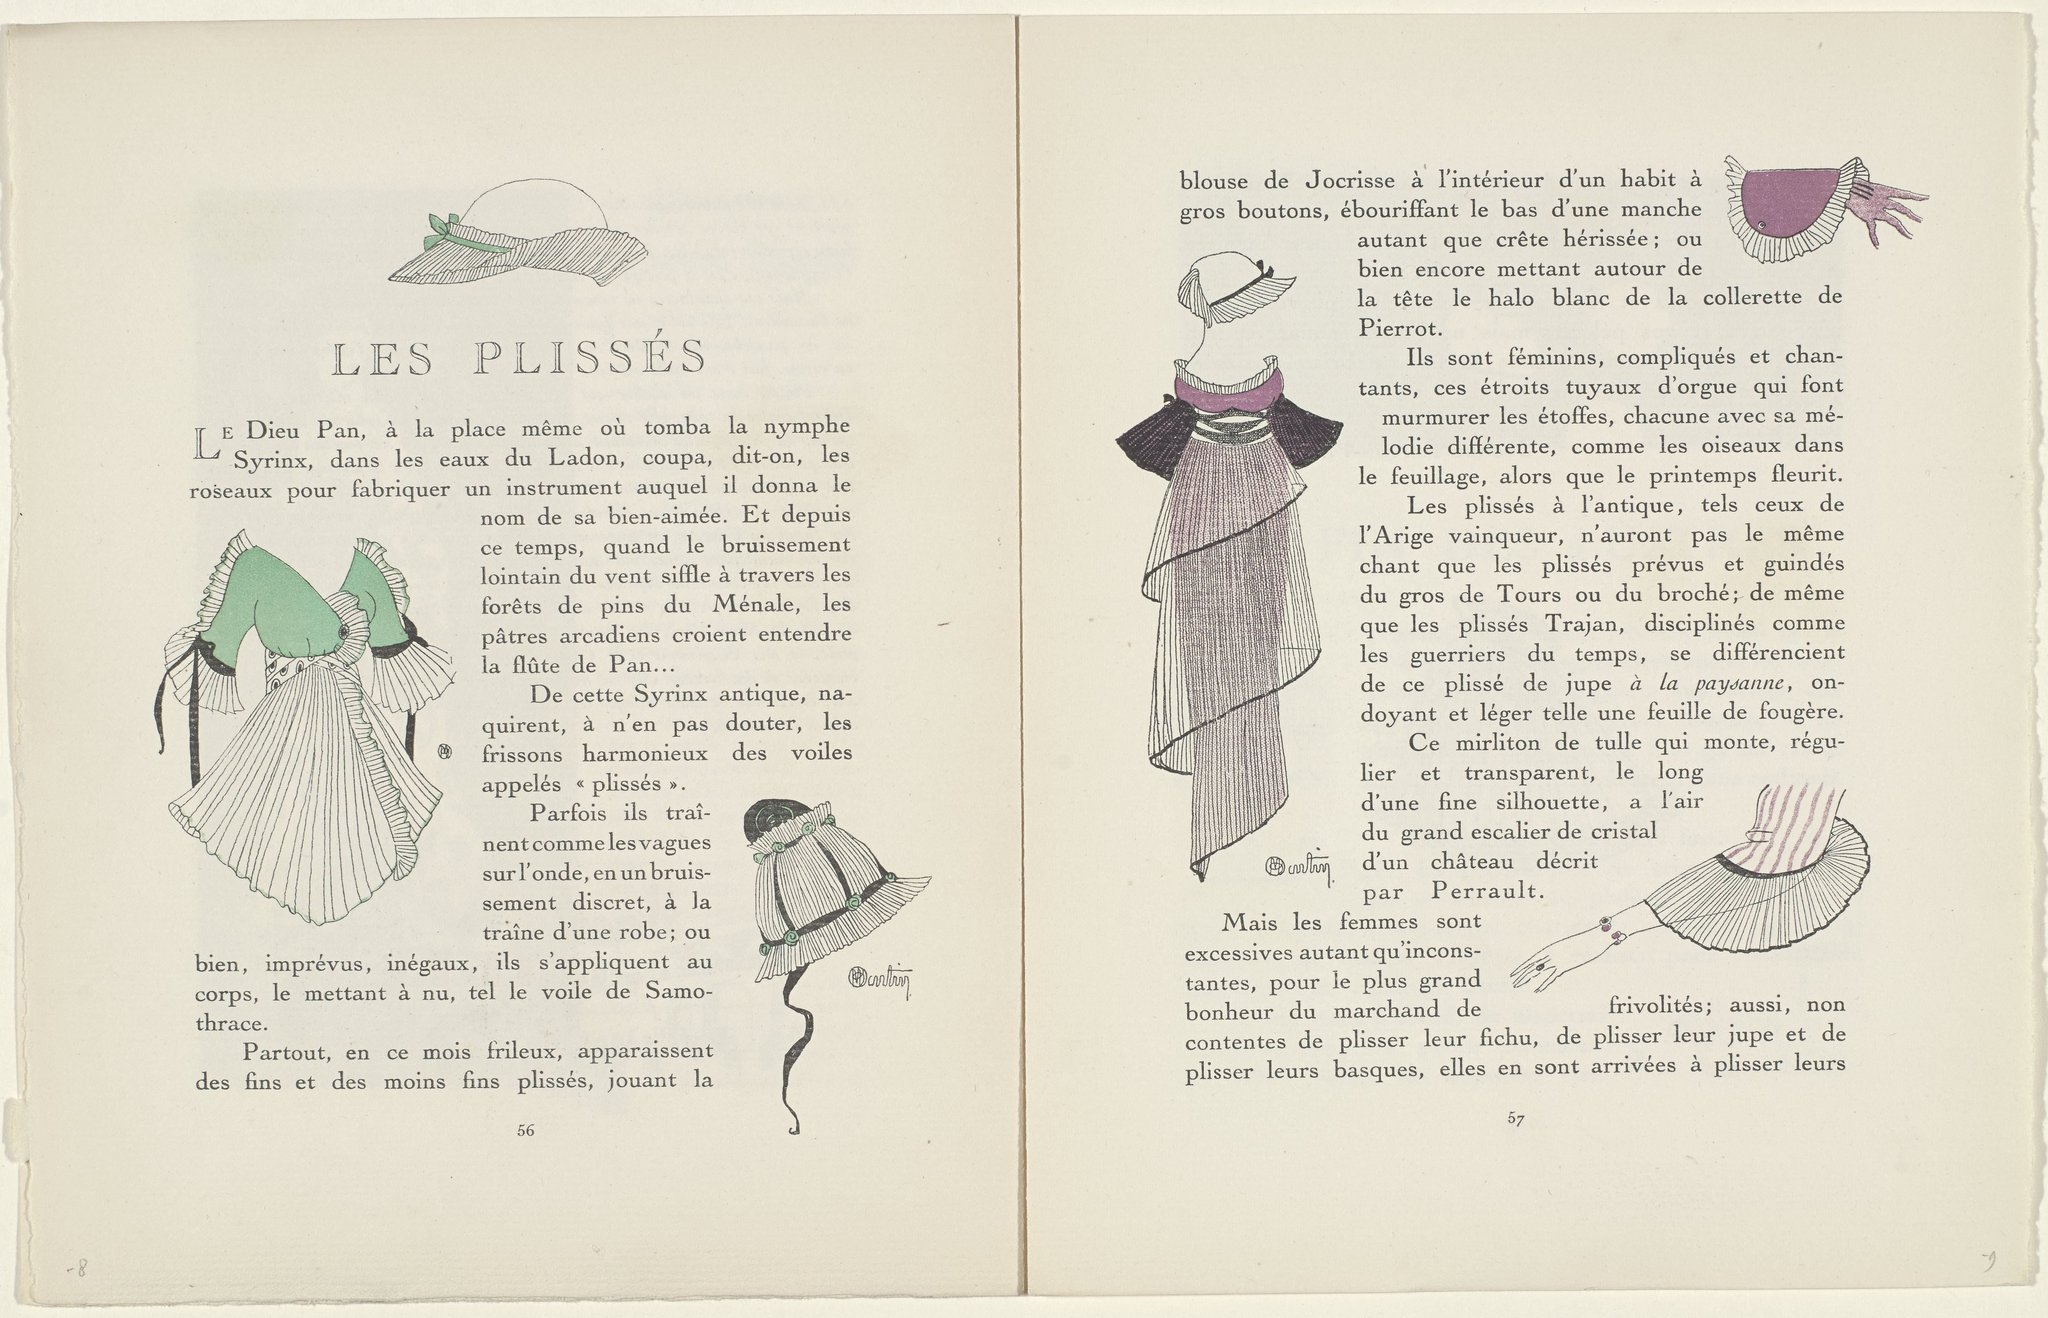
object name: fashion print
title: Gazette du Bon Ton, 1914 - No. 2: p. 57: Les Plissés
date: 1914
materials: paper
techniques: hand coloring, letterpress printing, lithograph, pochoir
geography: london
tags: fashion plates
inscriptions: date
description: Les Plissés. Tekst en illustraties van geplisseerde japon en geplisseerde manchetten. Pag. 57 in Gazette du Bon Ton 1914, No. 2.